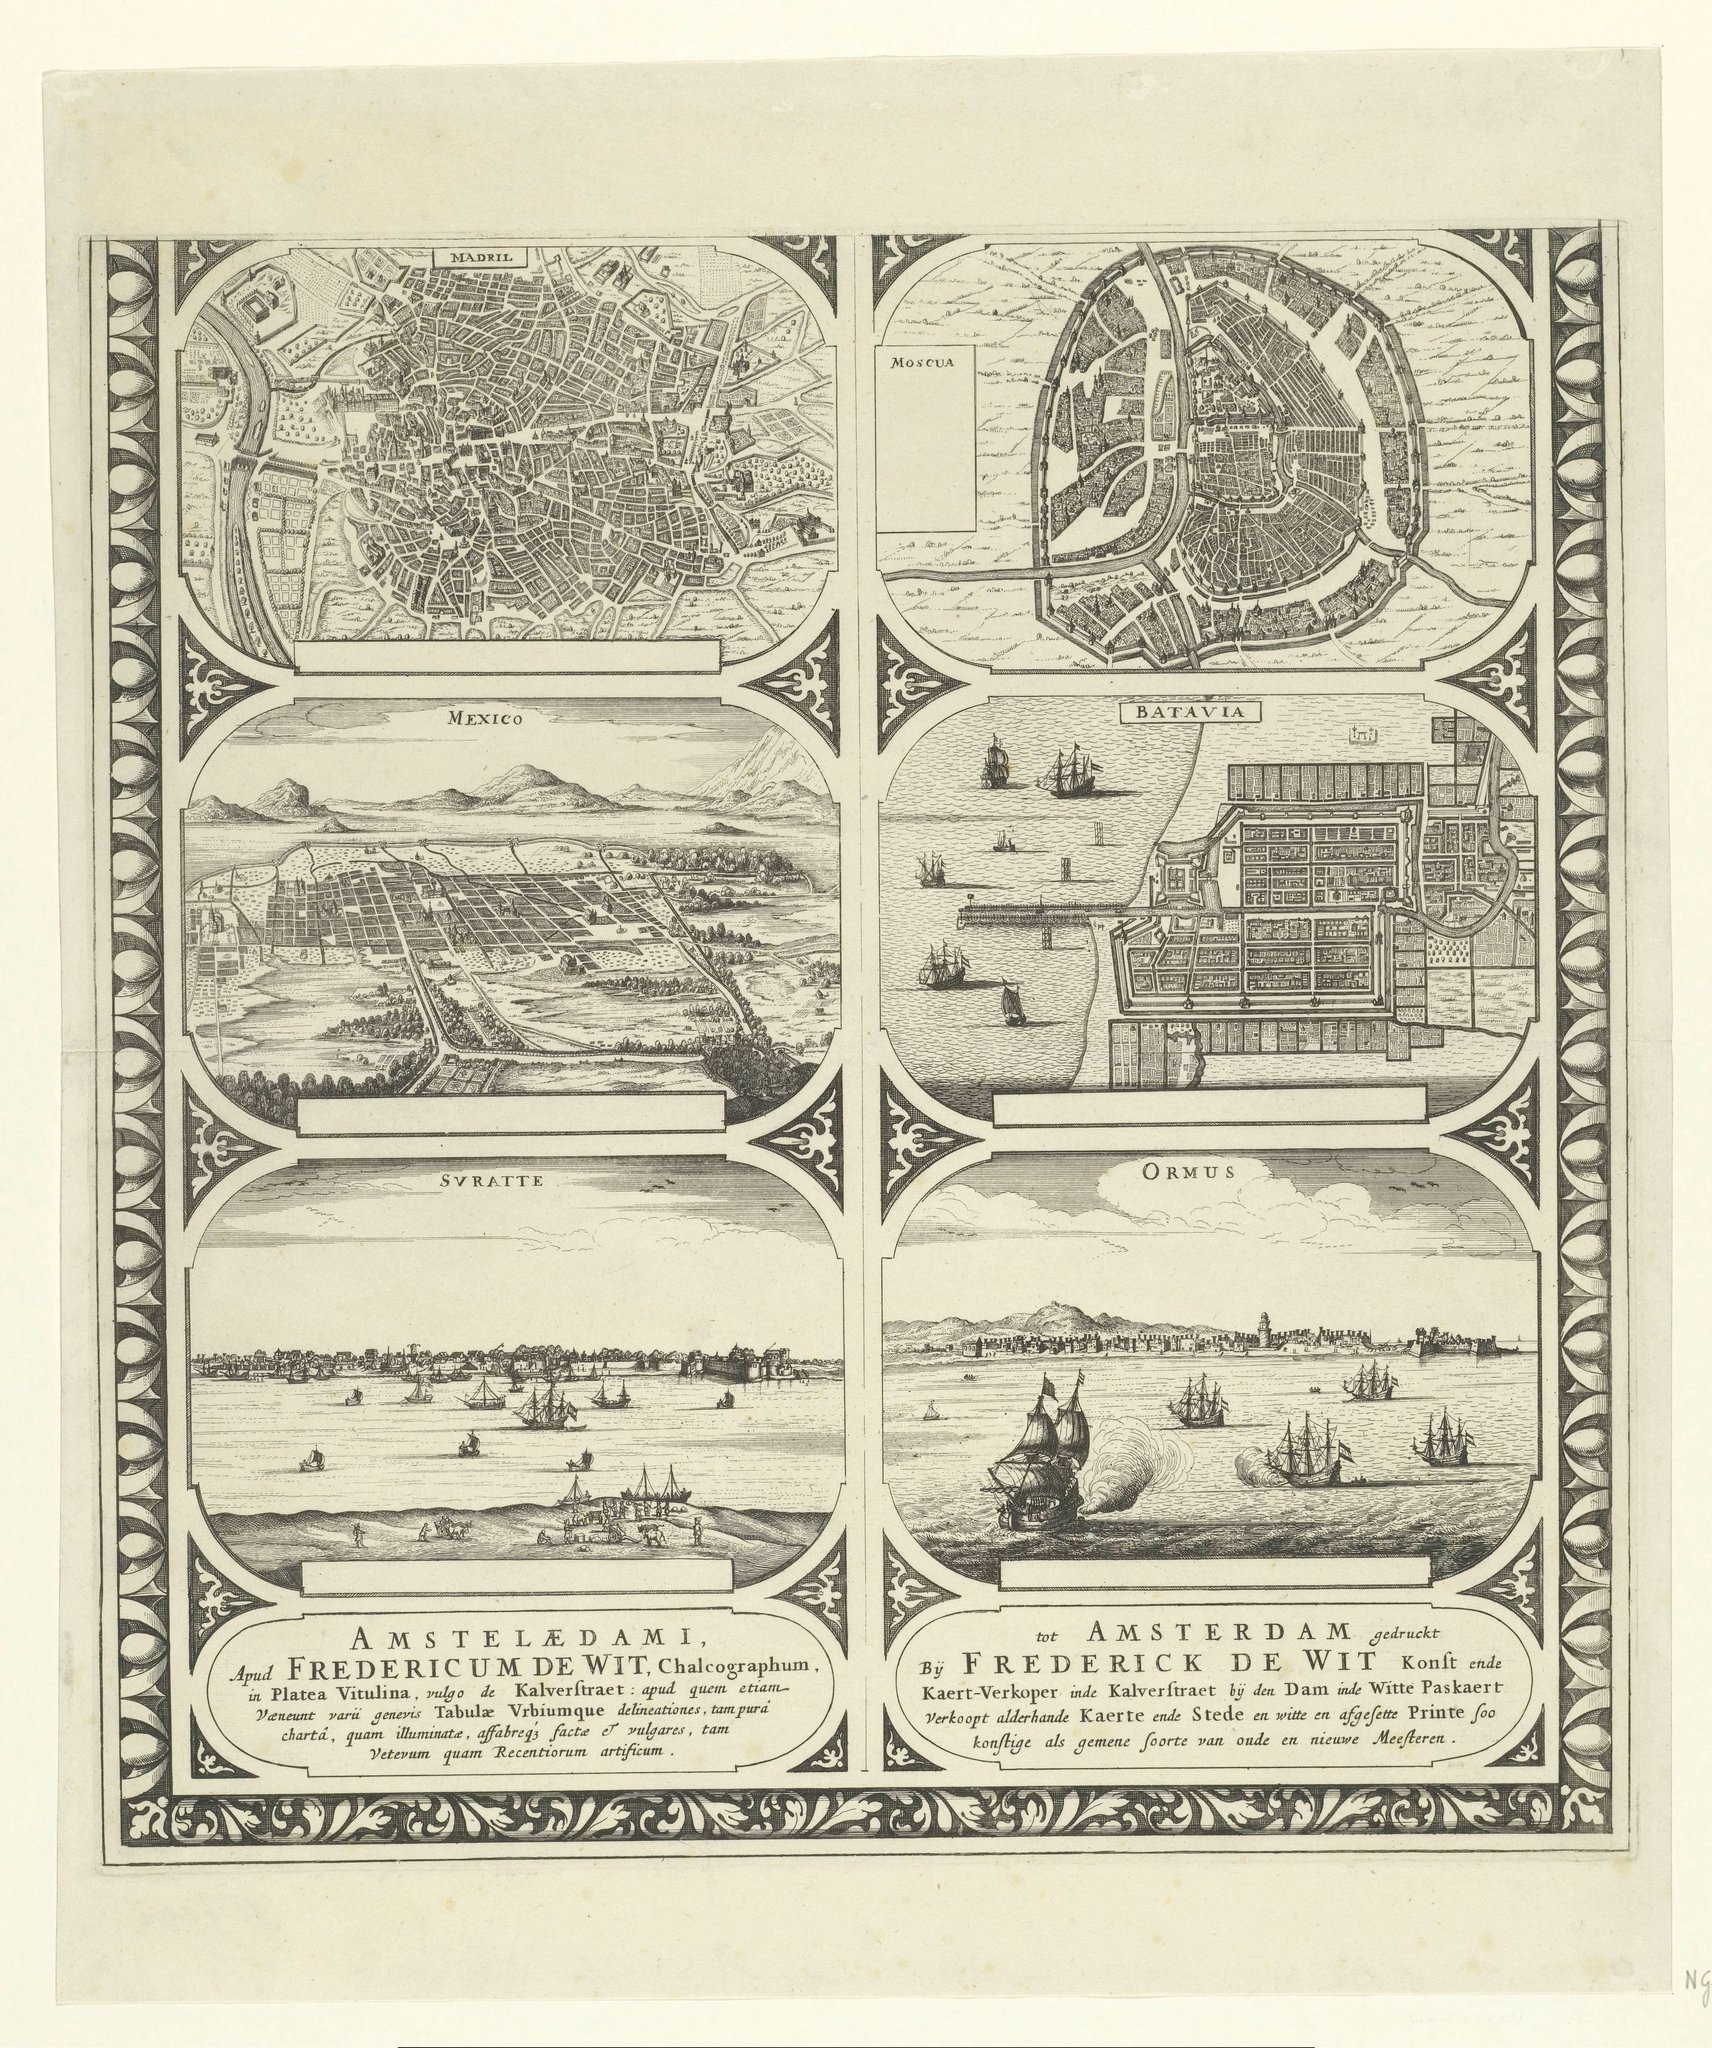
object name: print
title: Madril / Mexico / Svratte / Moscua / Batavia / Ormus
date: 1670-1672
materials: paper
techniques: etching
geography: amsterdam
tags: maps of cities, prospect of city, town panorama, silhouette of city, batavia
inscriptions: address: ‘tot AMSTERDAM gedruckt / Bij FREDERICK DE WIT Konst ende / Kaart-Verkoper inde Kalverstraat bij den Dam inde Witte Paskaert / Verkoopt alderhande Kaerte ende Stede en Witte en afgesette Printe soo / Konstige als gemene soorte van oude en nieuwe Meesteren’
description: Blad met twee verticale stroken, elk met drie plattegronden van of gezichten op de steden Madrid, Mexico, Suratte, Moskou, Batavia en Hormoz. Onderaan het adres van de uitgever in Latijn en Nederlands. Onversneden blad met zes randfiguren bedoeld om in stroken als omlijsting om een kaart van een werelddeel te plakken.